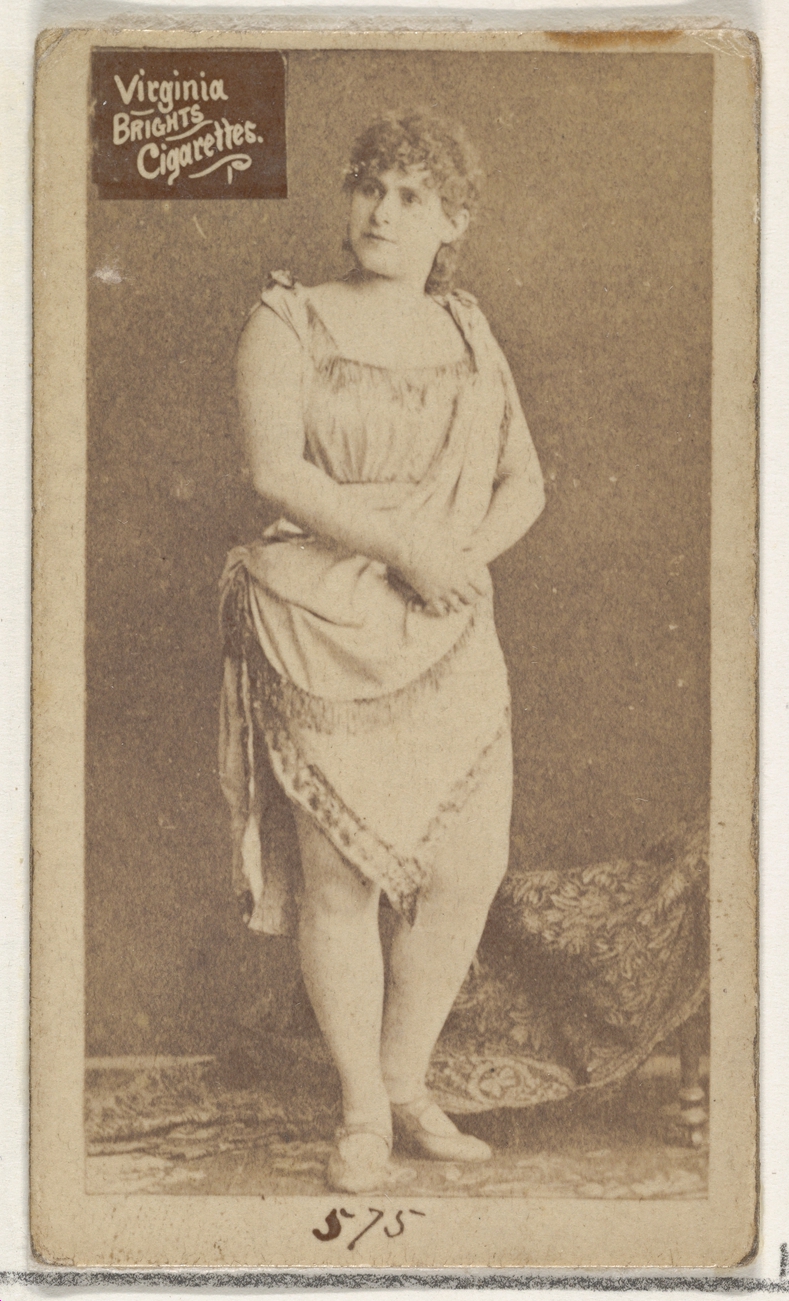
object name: photograph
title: Card 575, from the Actors and Actresses series (N45, Type 2) for Virginia Brights Cigarettes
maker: allen & ginter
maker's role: publisher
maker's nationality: american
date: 1888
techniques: albumen silver print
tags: portraits,women,actresses